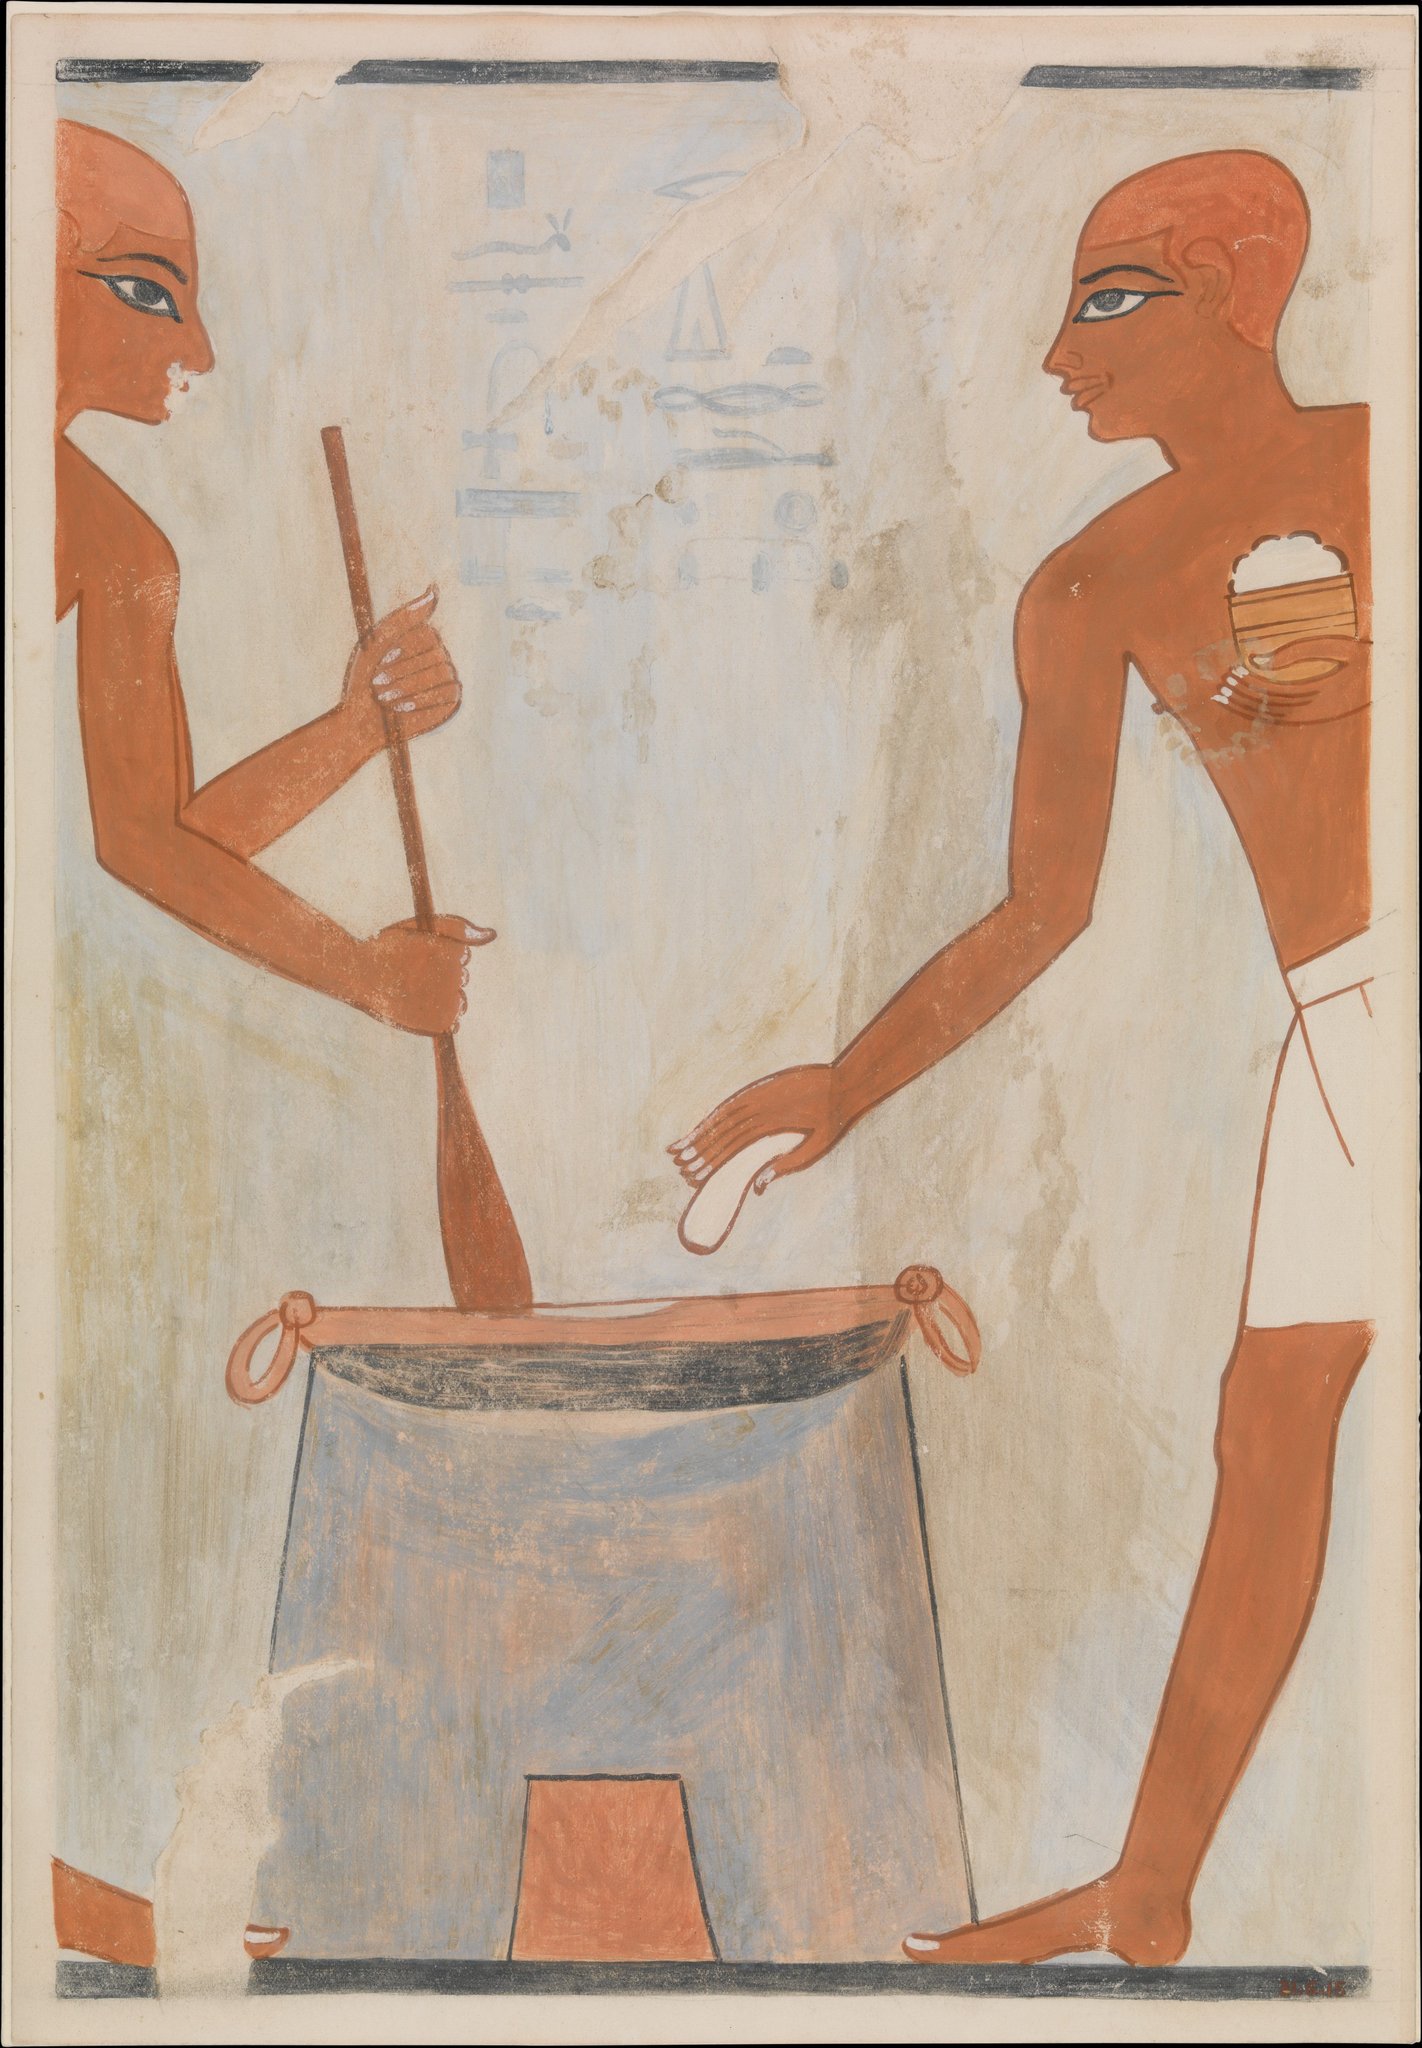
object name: facsimile, rekhmire tt 100, cooking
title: Cooking Cakes with Fat, Tomb of Rekhmire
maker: nina de garis davies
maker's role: artist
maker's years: 1881-1965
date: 1504-1425 BCE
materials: ink, paint, paper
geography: egypt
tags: food,men,working,cooking